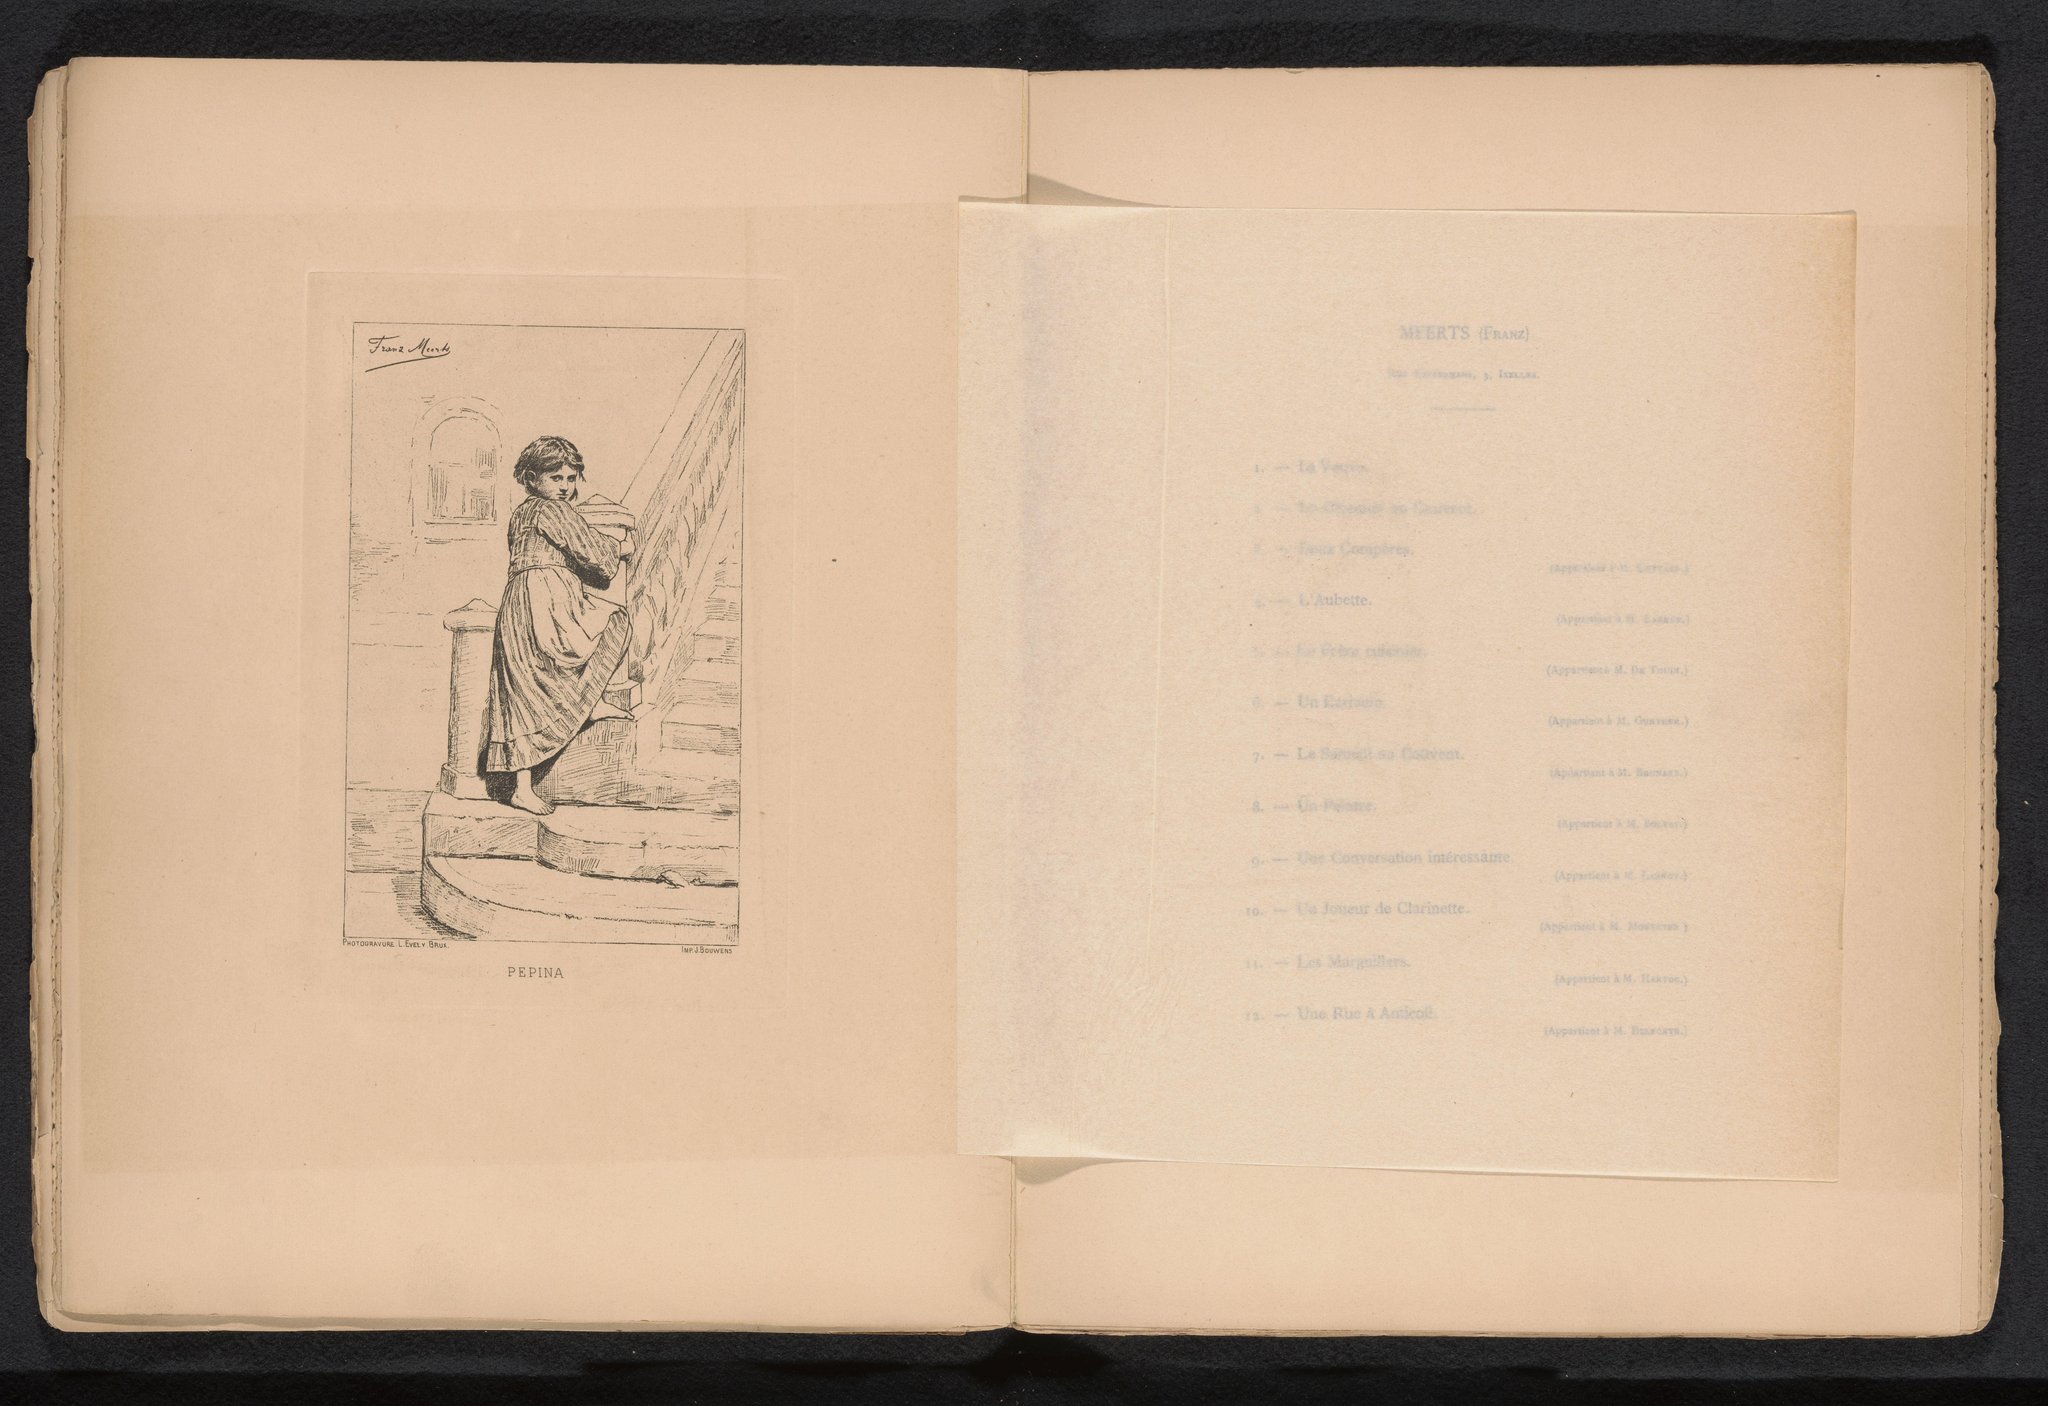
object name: page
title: Pepina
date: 1878-1883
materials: paper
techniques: photoaquatint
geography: brussels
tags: stairwell, child